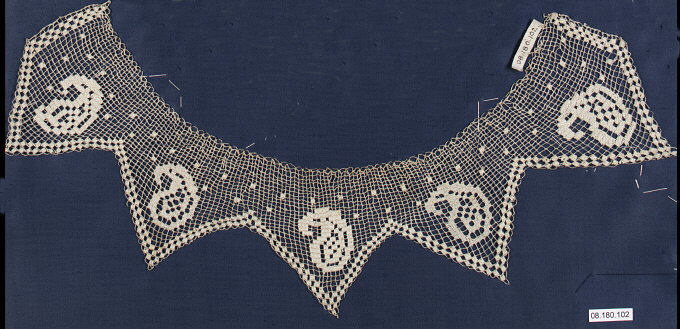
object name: collar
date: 1801-1900